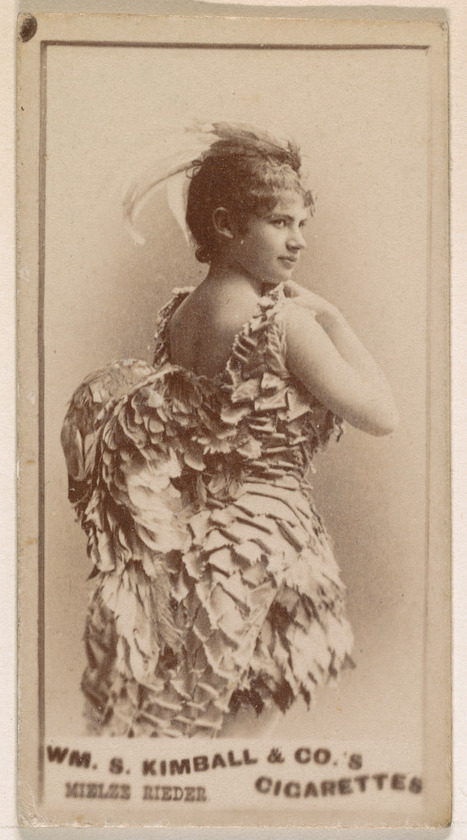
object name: photograph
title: Mieles Rieder, from the Actresses series (N203) issued by Wm. S. Kimball & Co.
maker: william s. kimball & company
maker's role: publisher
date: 1889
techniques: color lithograph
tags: portraits,women,actresses